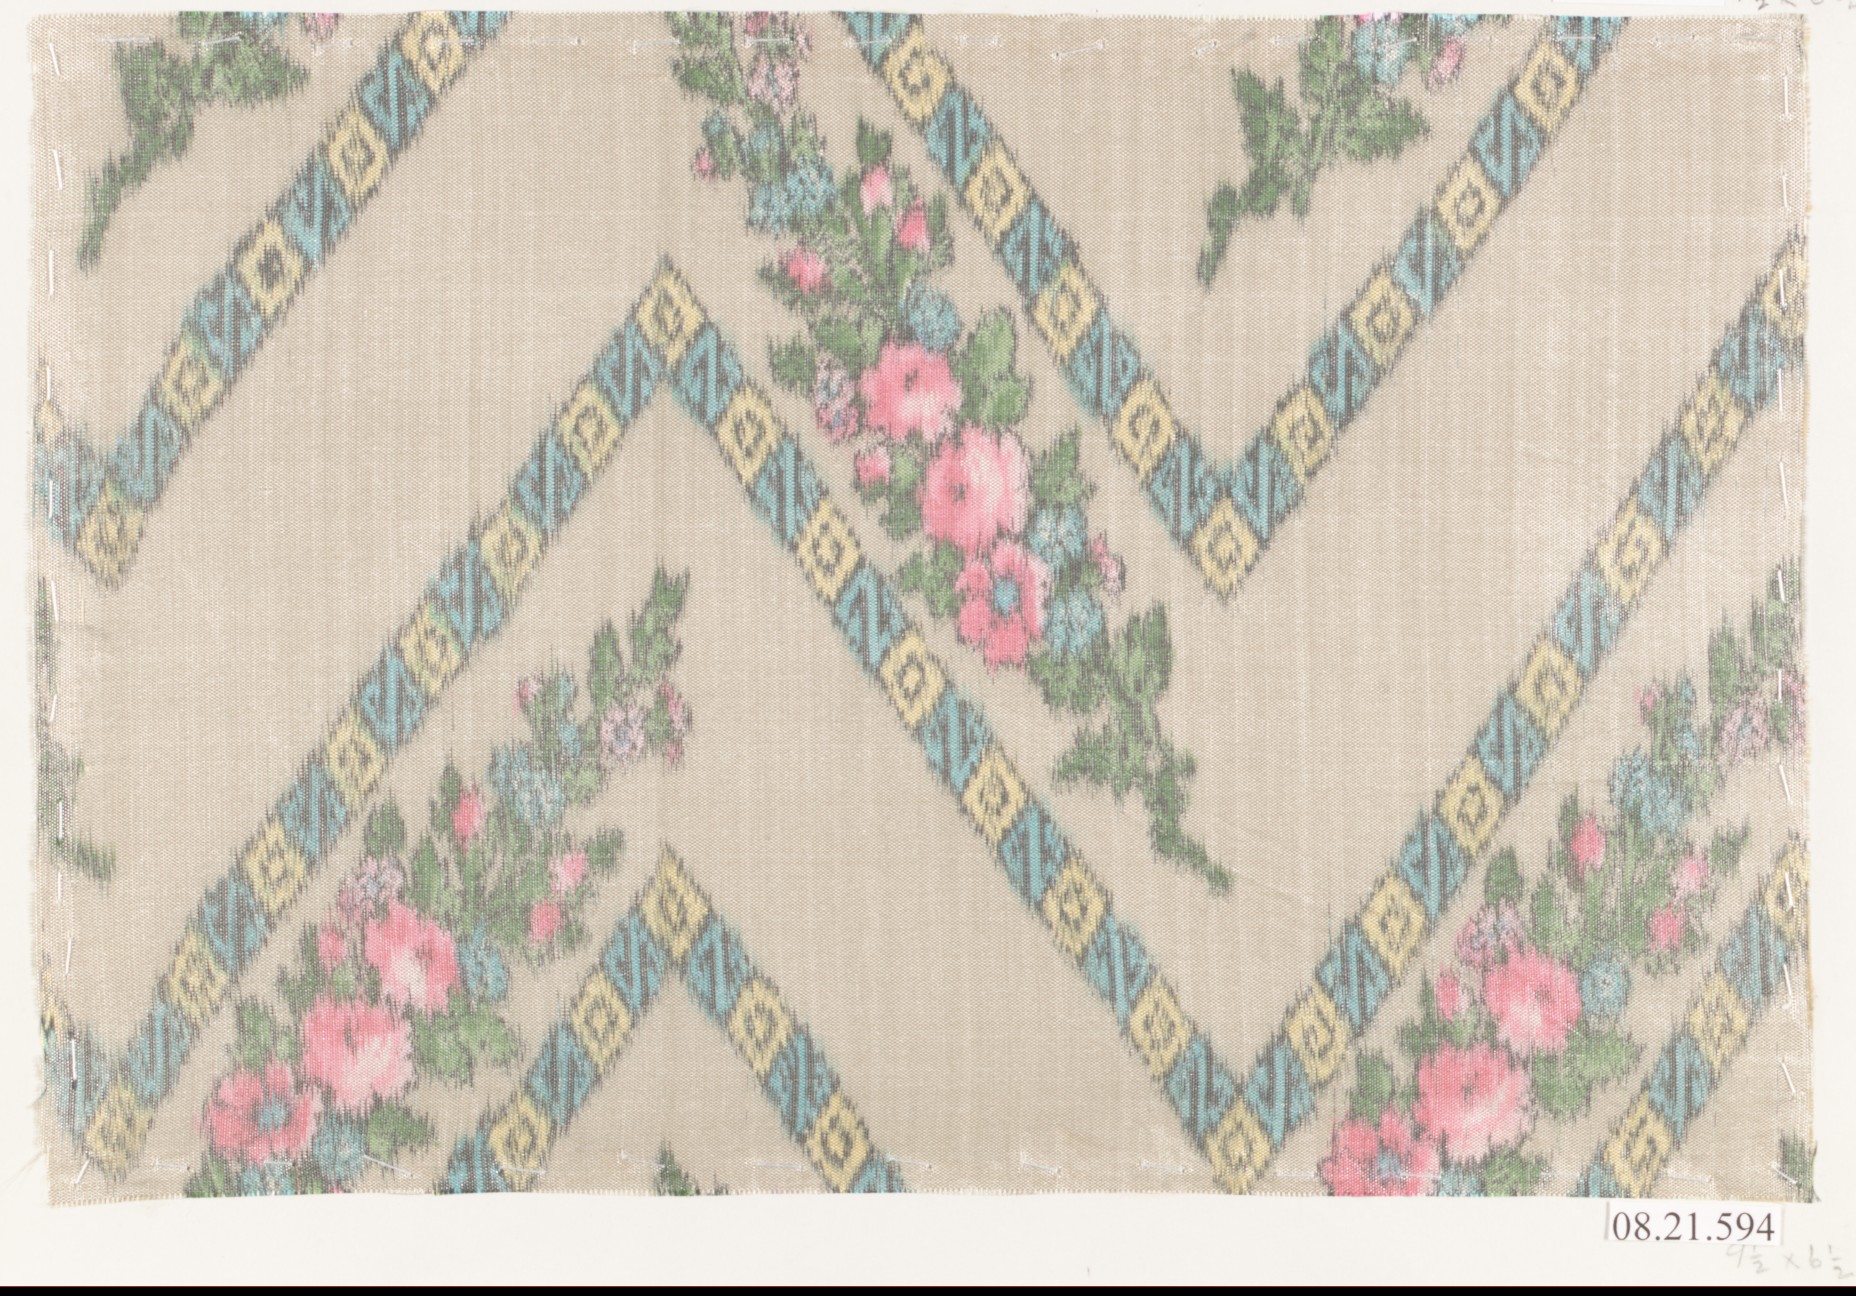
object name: textile sample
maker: Anonymous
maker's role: designer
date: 1900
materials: silk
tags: flowers